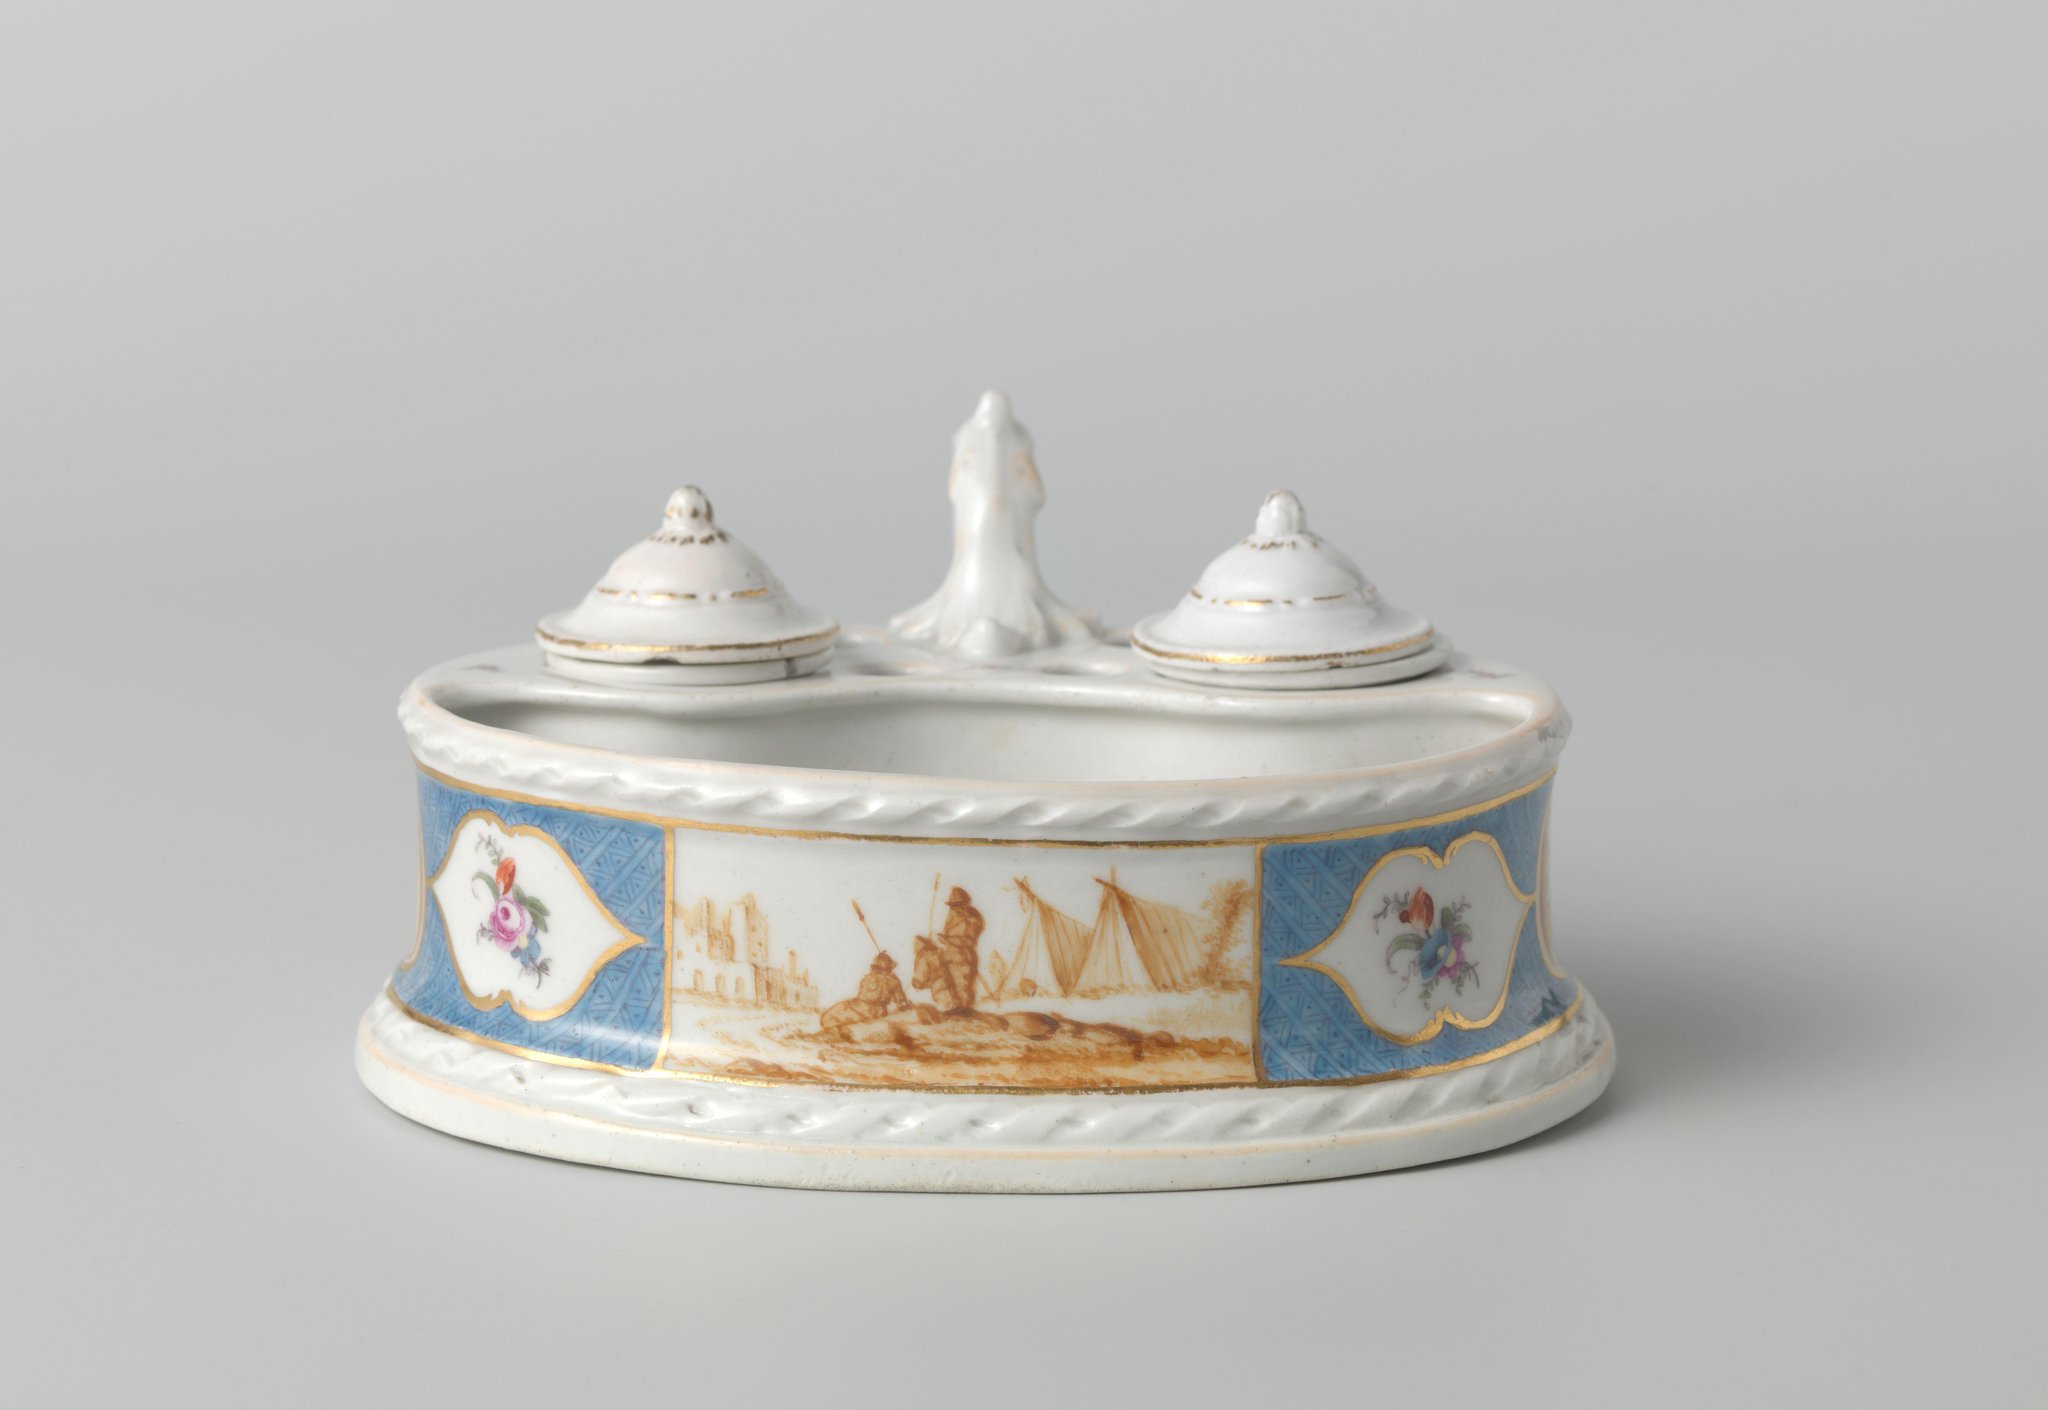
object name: inkwell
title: Deksel van zandstrooier of inktpot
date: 1778-1782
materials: porcelain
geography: loosdrecht